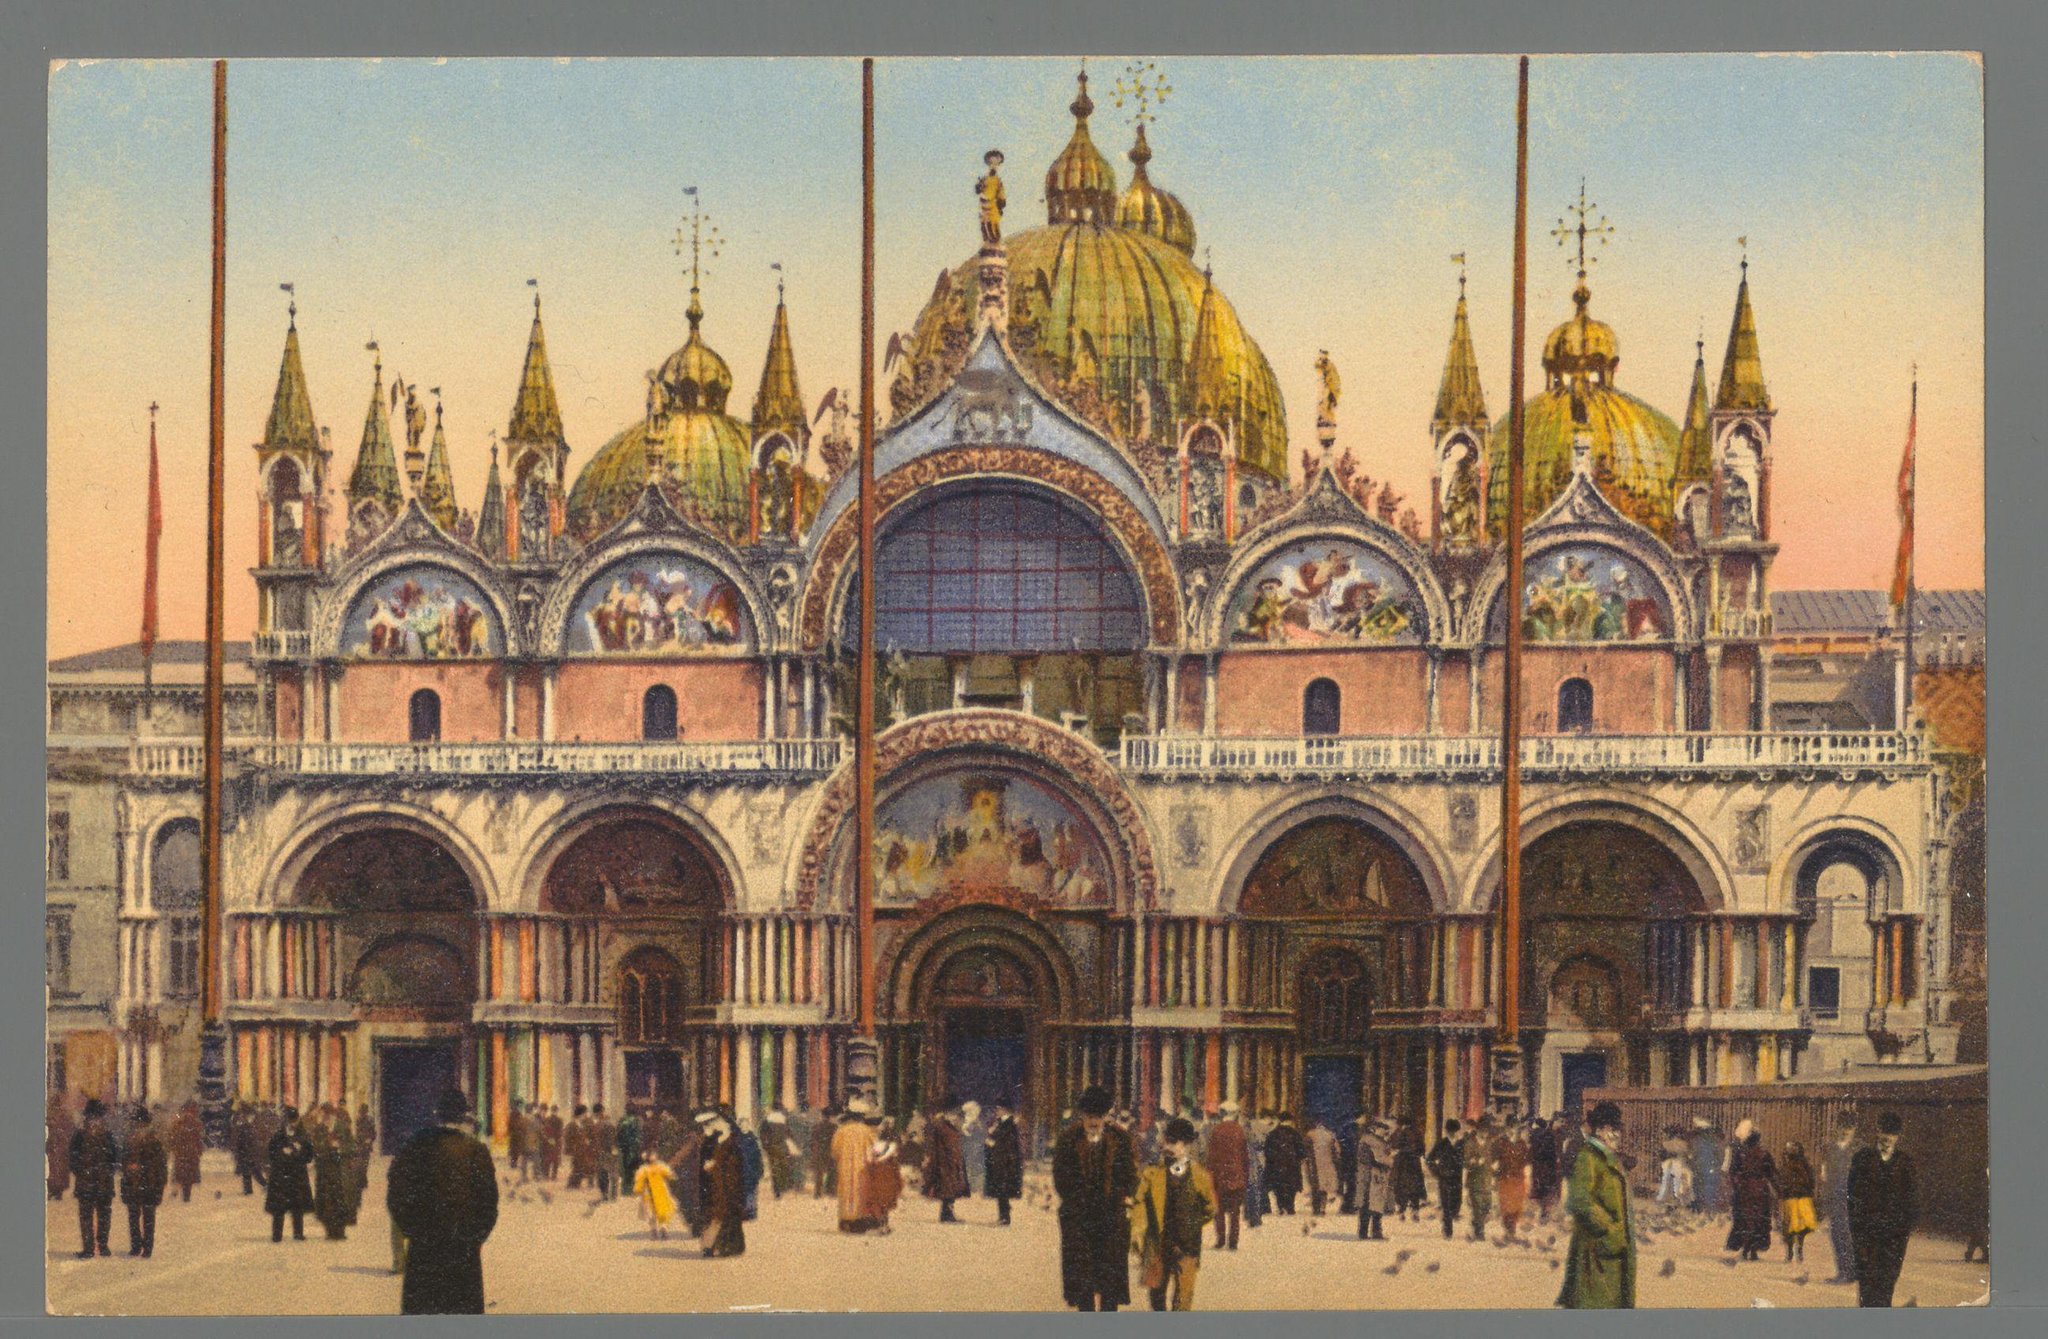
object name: ansichtkaart, prentbriefkaart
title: Venezia. S. Marco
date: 1903-1925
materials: cardboard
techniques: lithograph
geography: zurich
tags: church (exterior), square, place, circus, etc. (+ city(-scape) with figures, staffage)